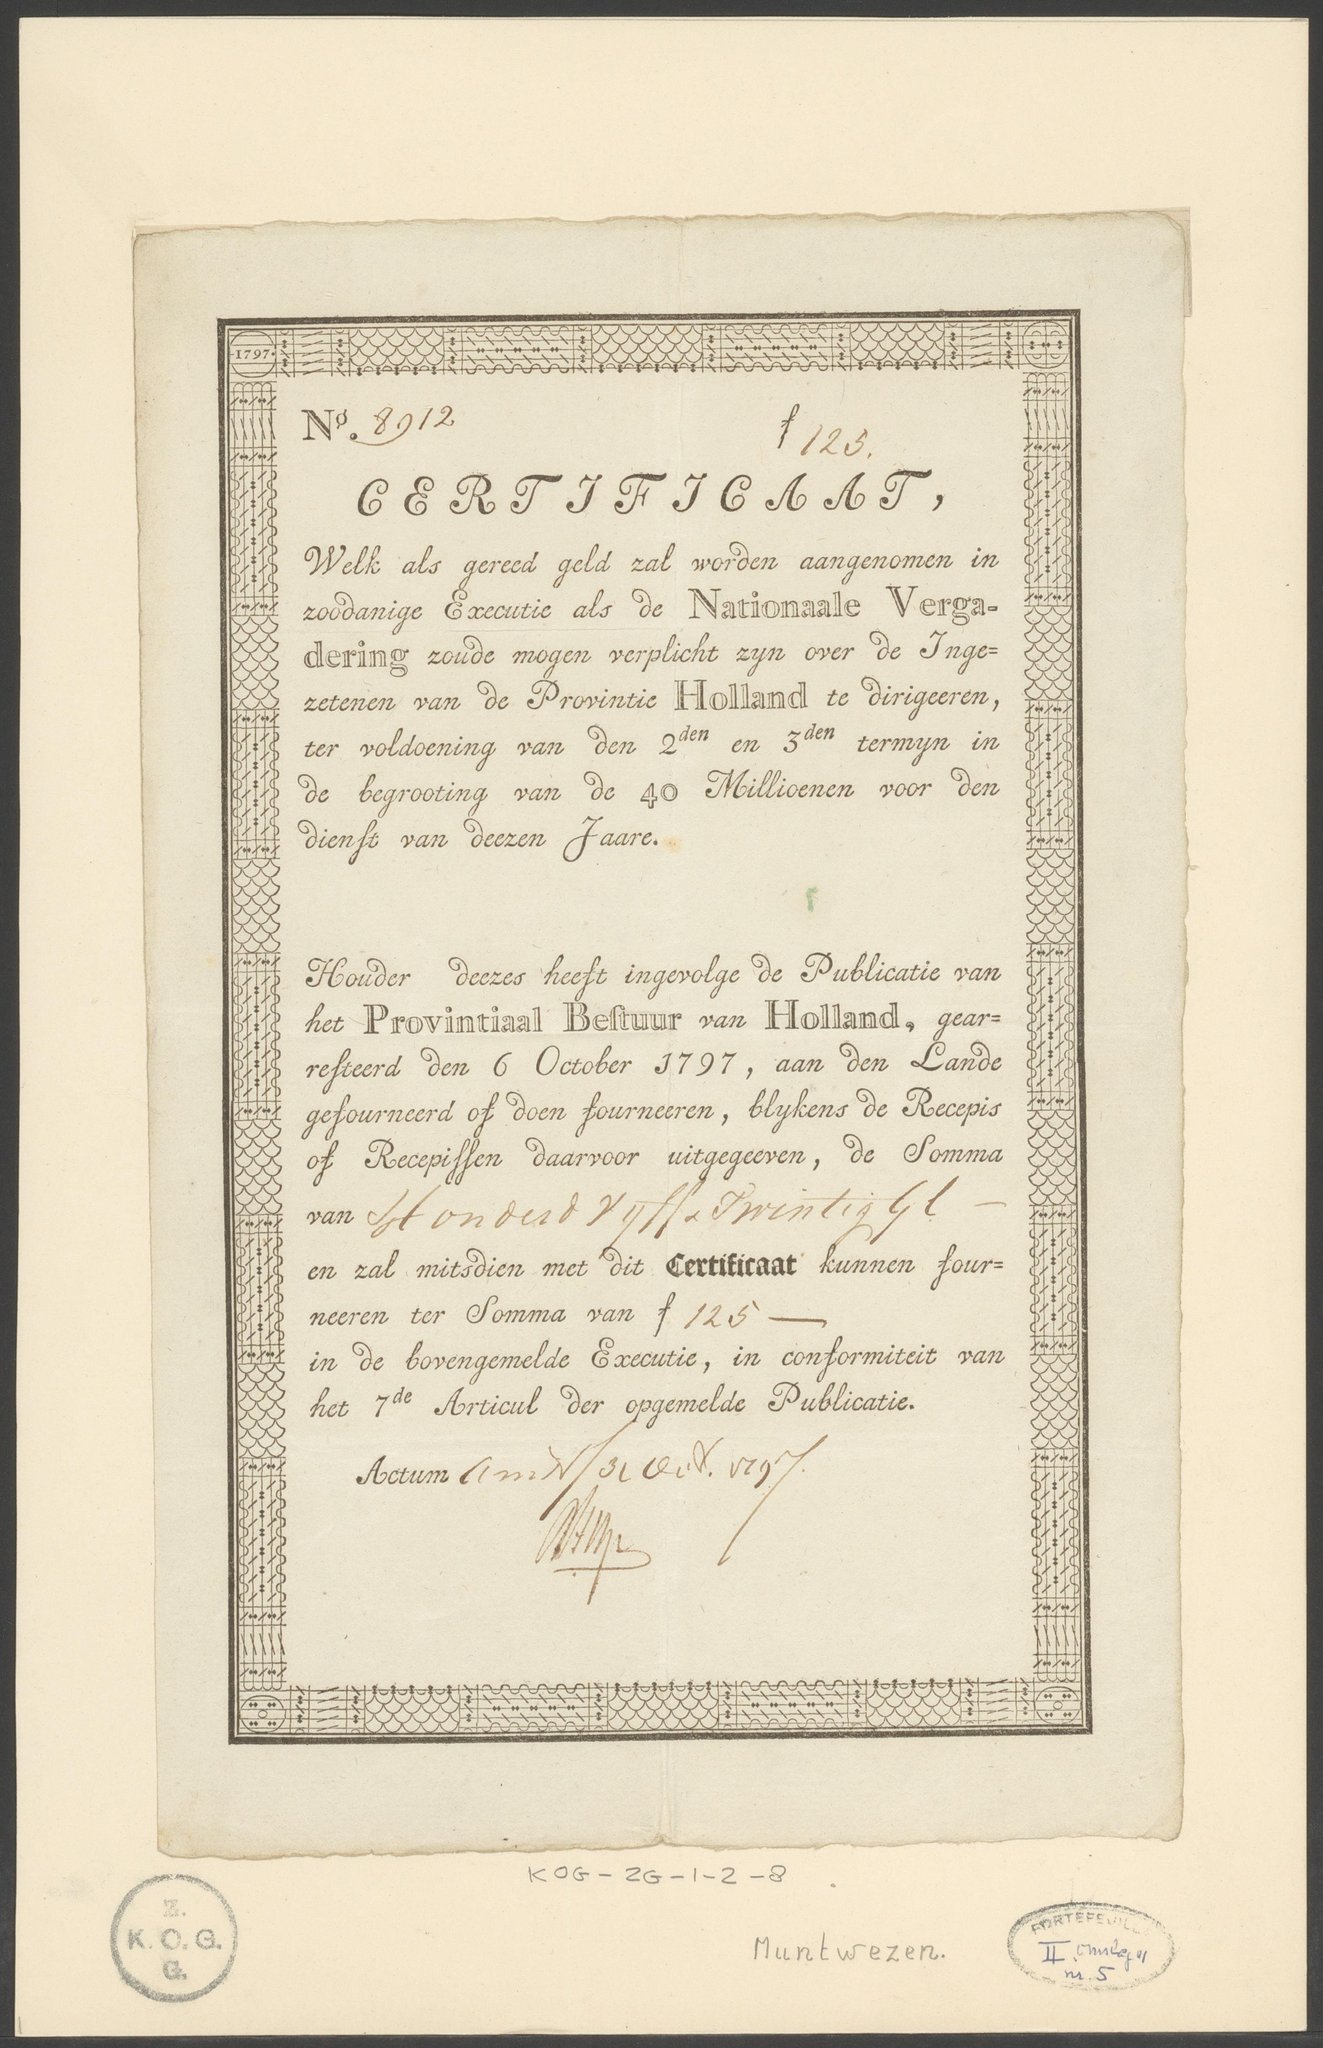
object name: text sheet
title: Certificaat, Welk als gereed geld zal worden aangenomen in zoodanige Executie als de Nationale Vergadering zoude mogen verplicht zyn over de Ingezetenen van de Provintie Holland (...)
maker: Anonymous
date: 1797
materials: ink, paper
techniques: etching, letterpress printing, pen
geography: netherlands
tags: cheque, draft, bill of exchange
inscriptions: collector's mark: Lugt 1641, collector's mark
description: Certificaat nr. 8912 van de provincie Holland voor het bedrag van 125 gulden, 31 oktober 1797. Voorgedrukt blad met ornamentele kader, ingevuld en ondertekend met pen in bruin. Onderwerpsrubrieken binnen de Atlas Zeden en Gewoonten: Regeering, Muntwezen.